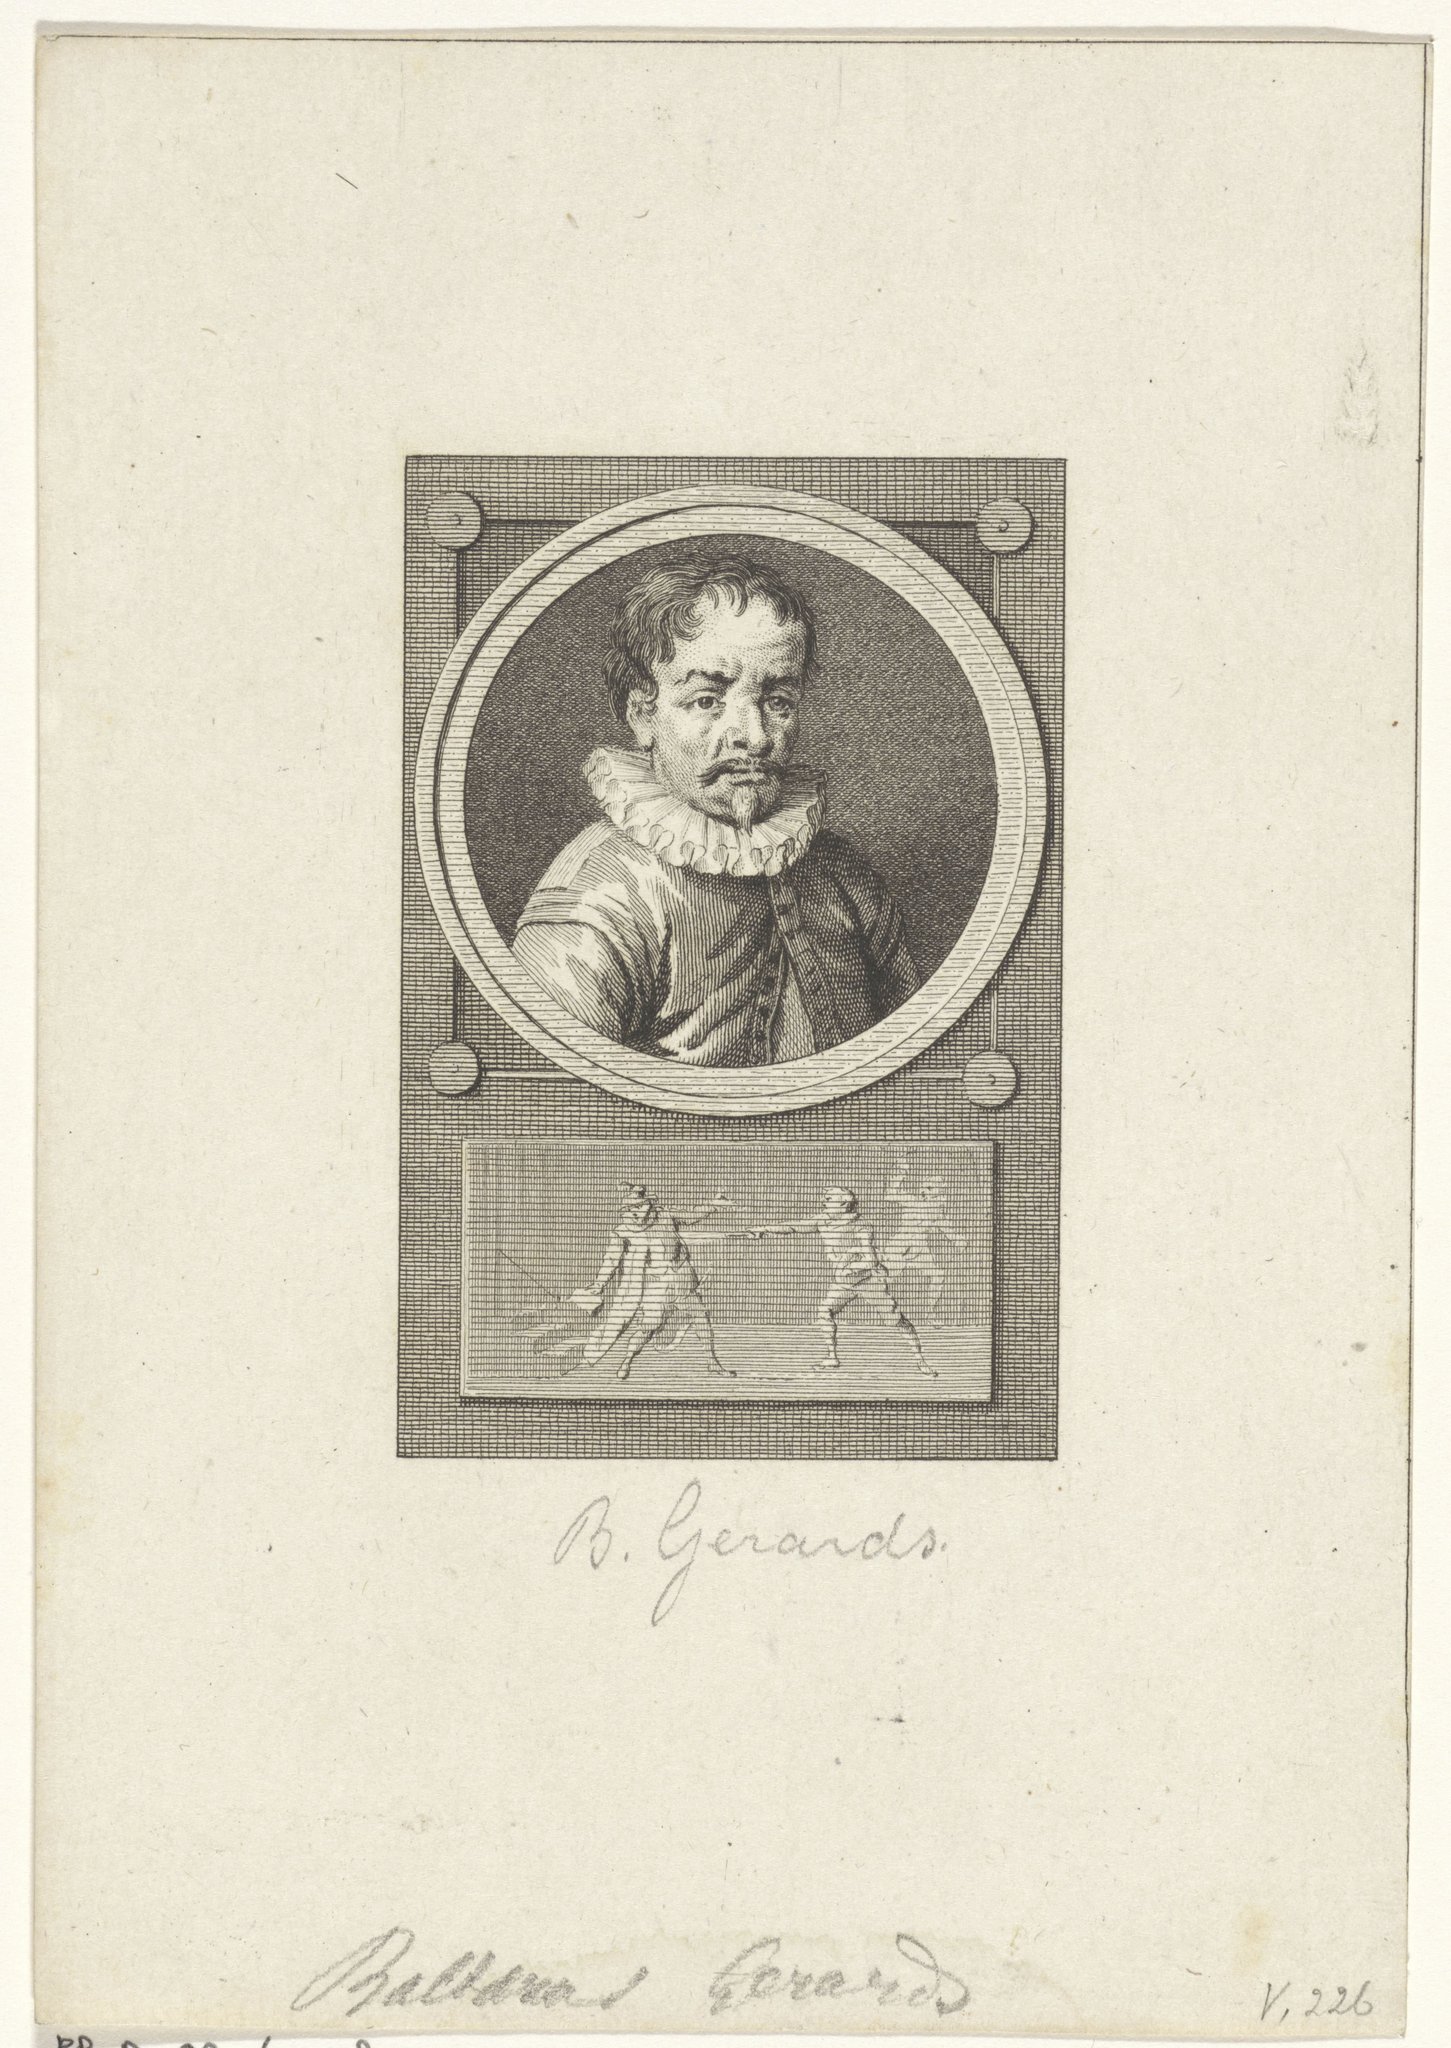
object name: print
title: Portret van Balthasar Gerards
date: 1783-1795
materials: paper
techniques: etching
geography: amsterdam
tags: delft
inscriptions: collector's mark: Lugt 2228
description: Latere staat prent gebruikt in: Fokke, Jan. Geschiedenissen der Vereenigde Nederlanden voor de vaderlandsche jeugd Ie-XXVste deel. Amsterdam: Johannes Allart, 1783-1795. Deel V.